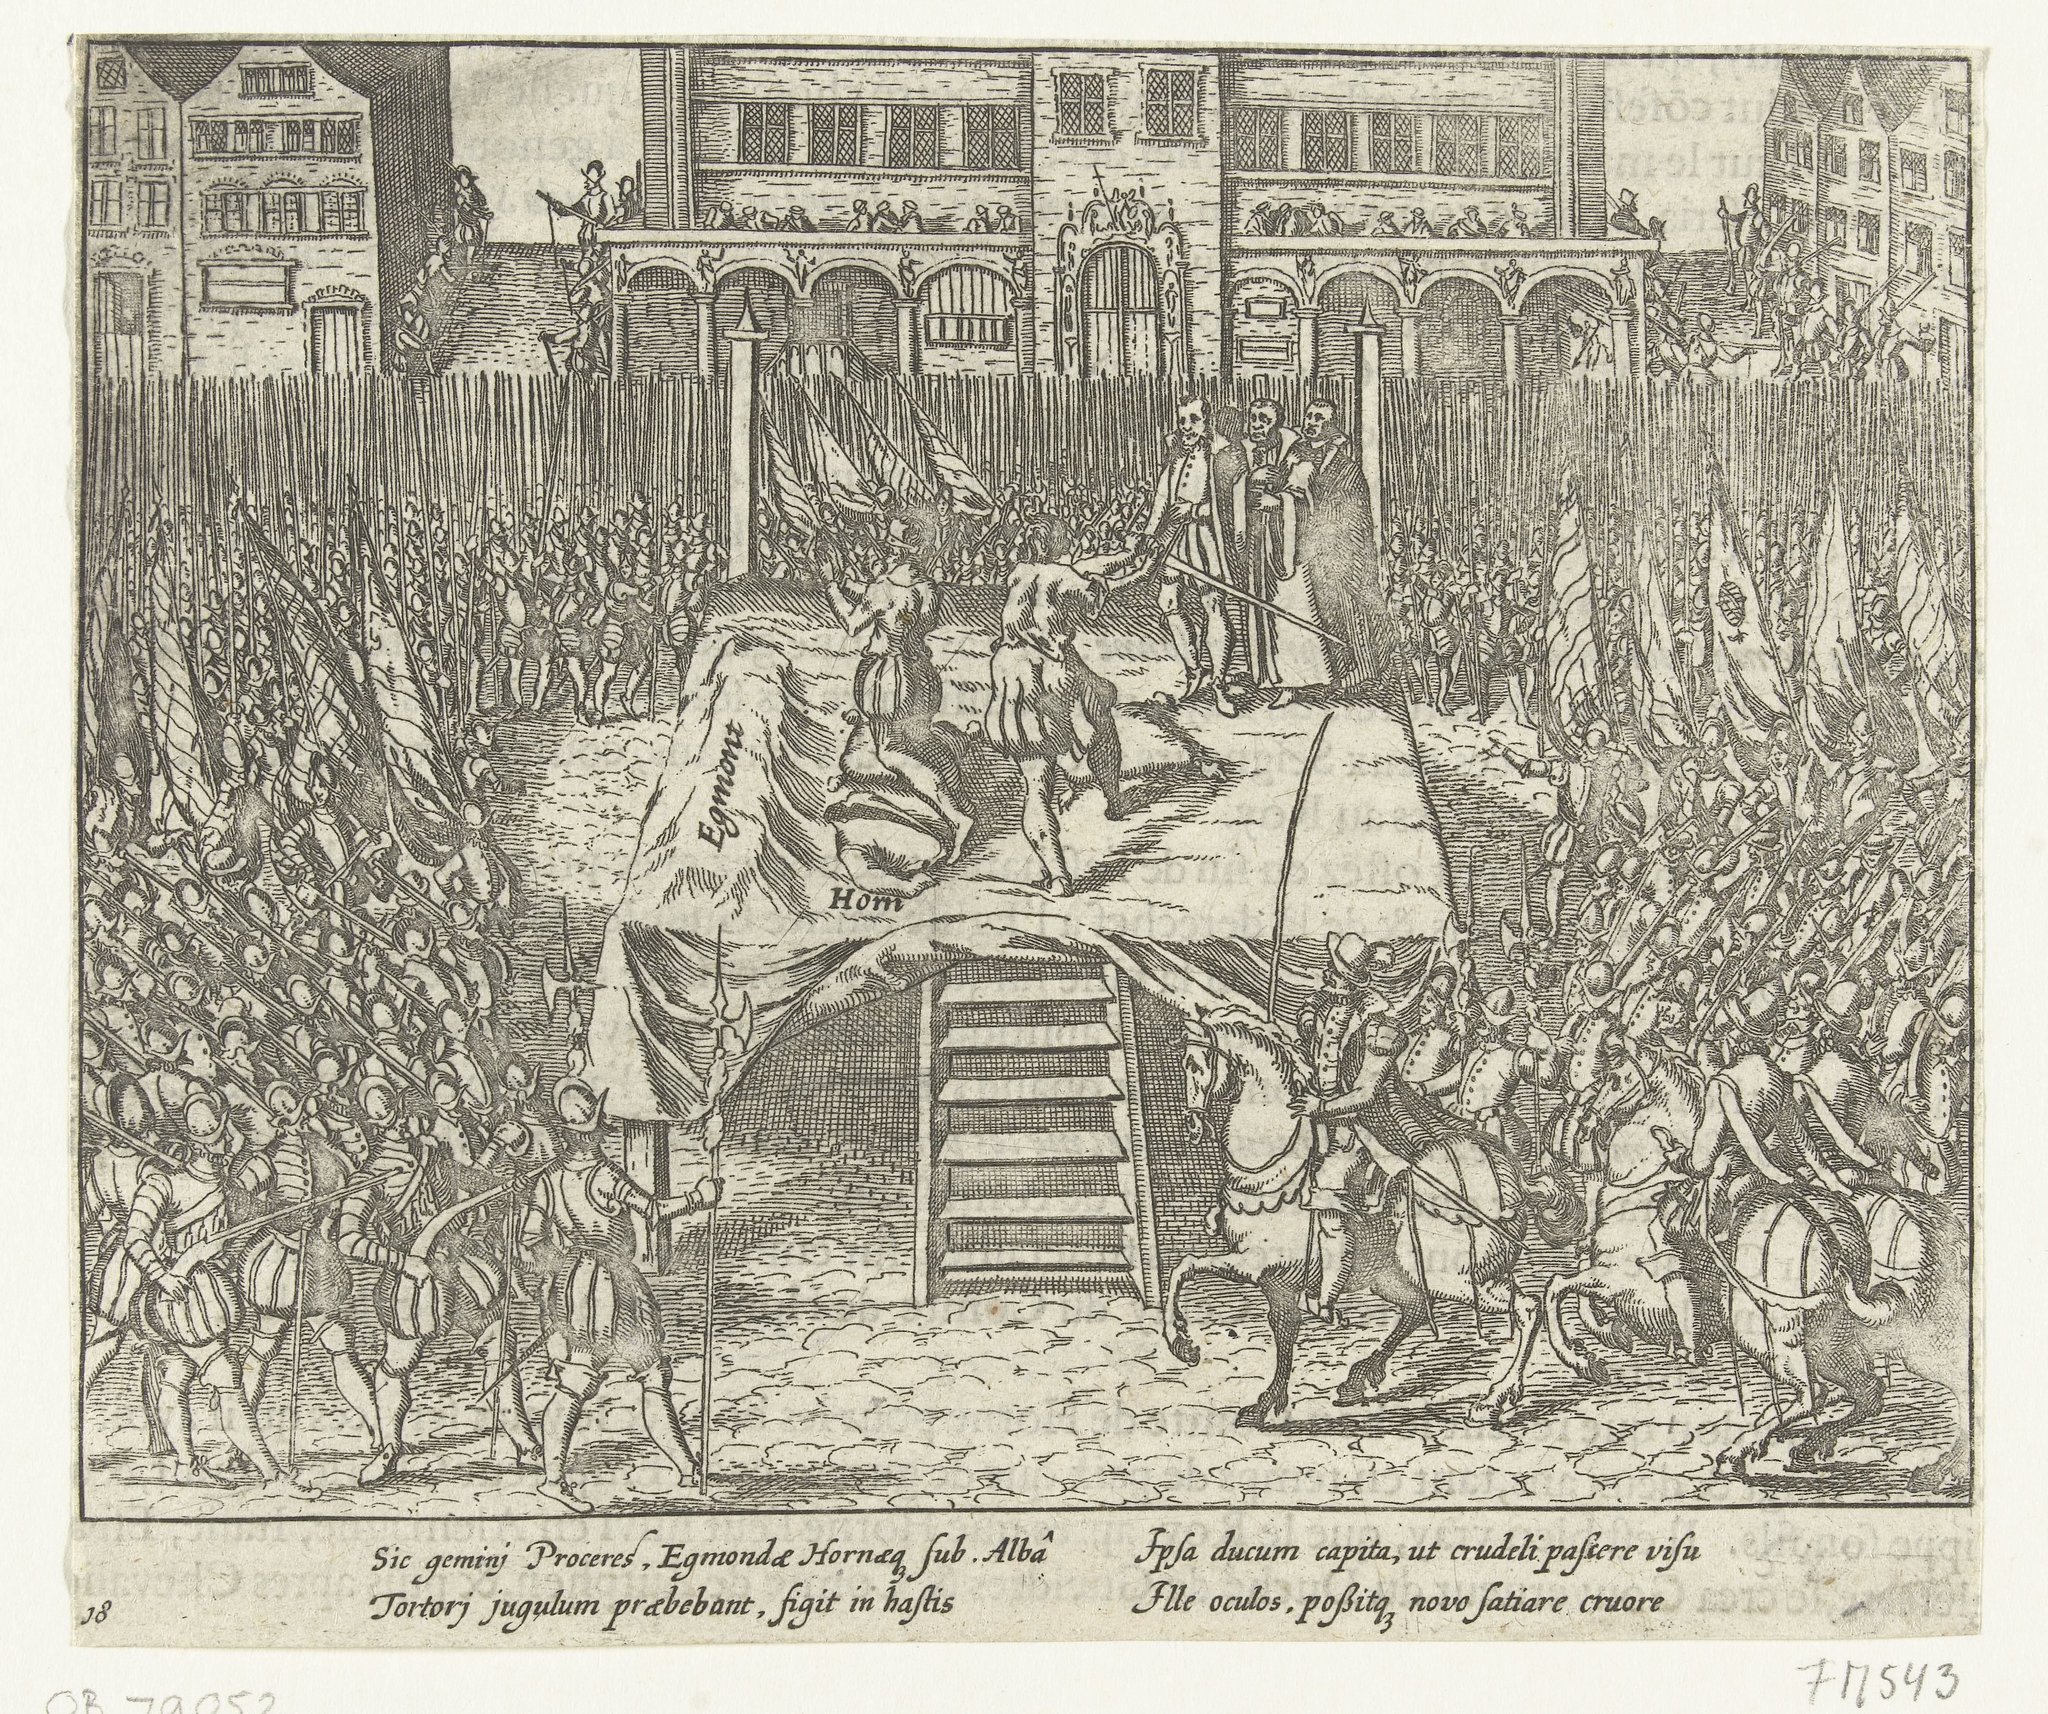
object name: history print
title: Executie van Egmond en Horne, 1568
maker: Anonymous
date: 1613-1615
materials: paper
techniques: etching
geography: germany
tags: brussels, earl, on the scaffold or place of execution, violent death by beheading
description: De onthoofding van Egmond en Horne op de Grote Markt te Brussel, 5 juni 1568. Horne knielt geblinddoekt, het lichaam van Egmond ligt onder een kleed. Terechtstelling op een schavot omgeven door soldaten van Alva. Met onderschrift van 4 regels in het Latijn. Genummerd: 18. Bedrukt op achterzijde met tekst in het Frans.